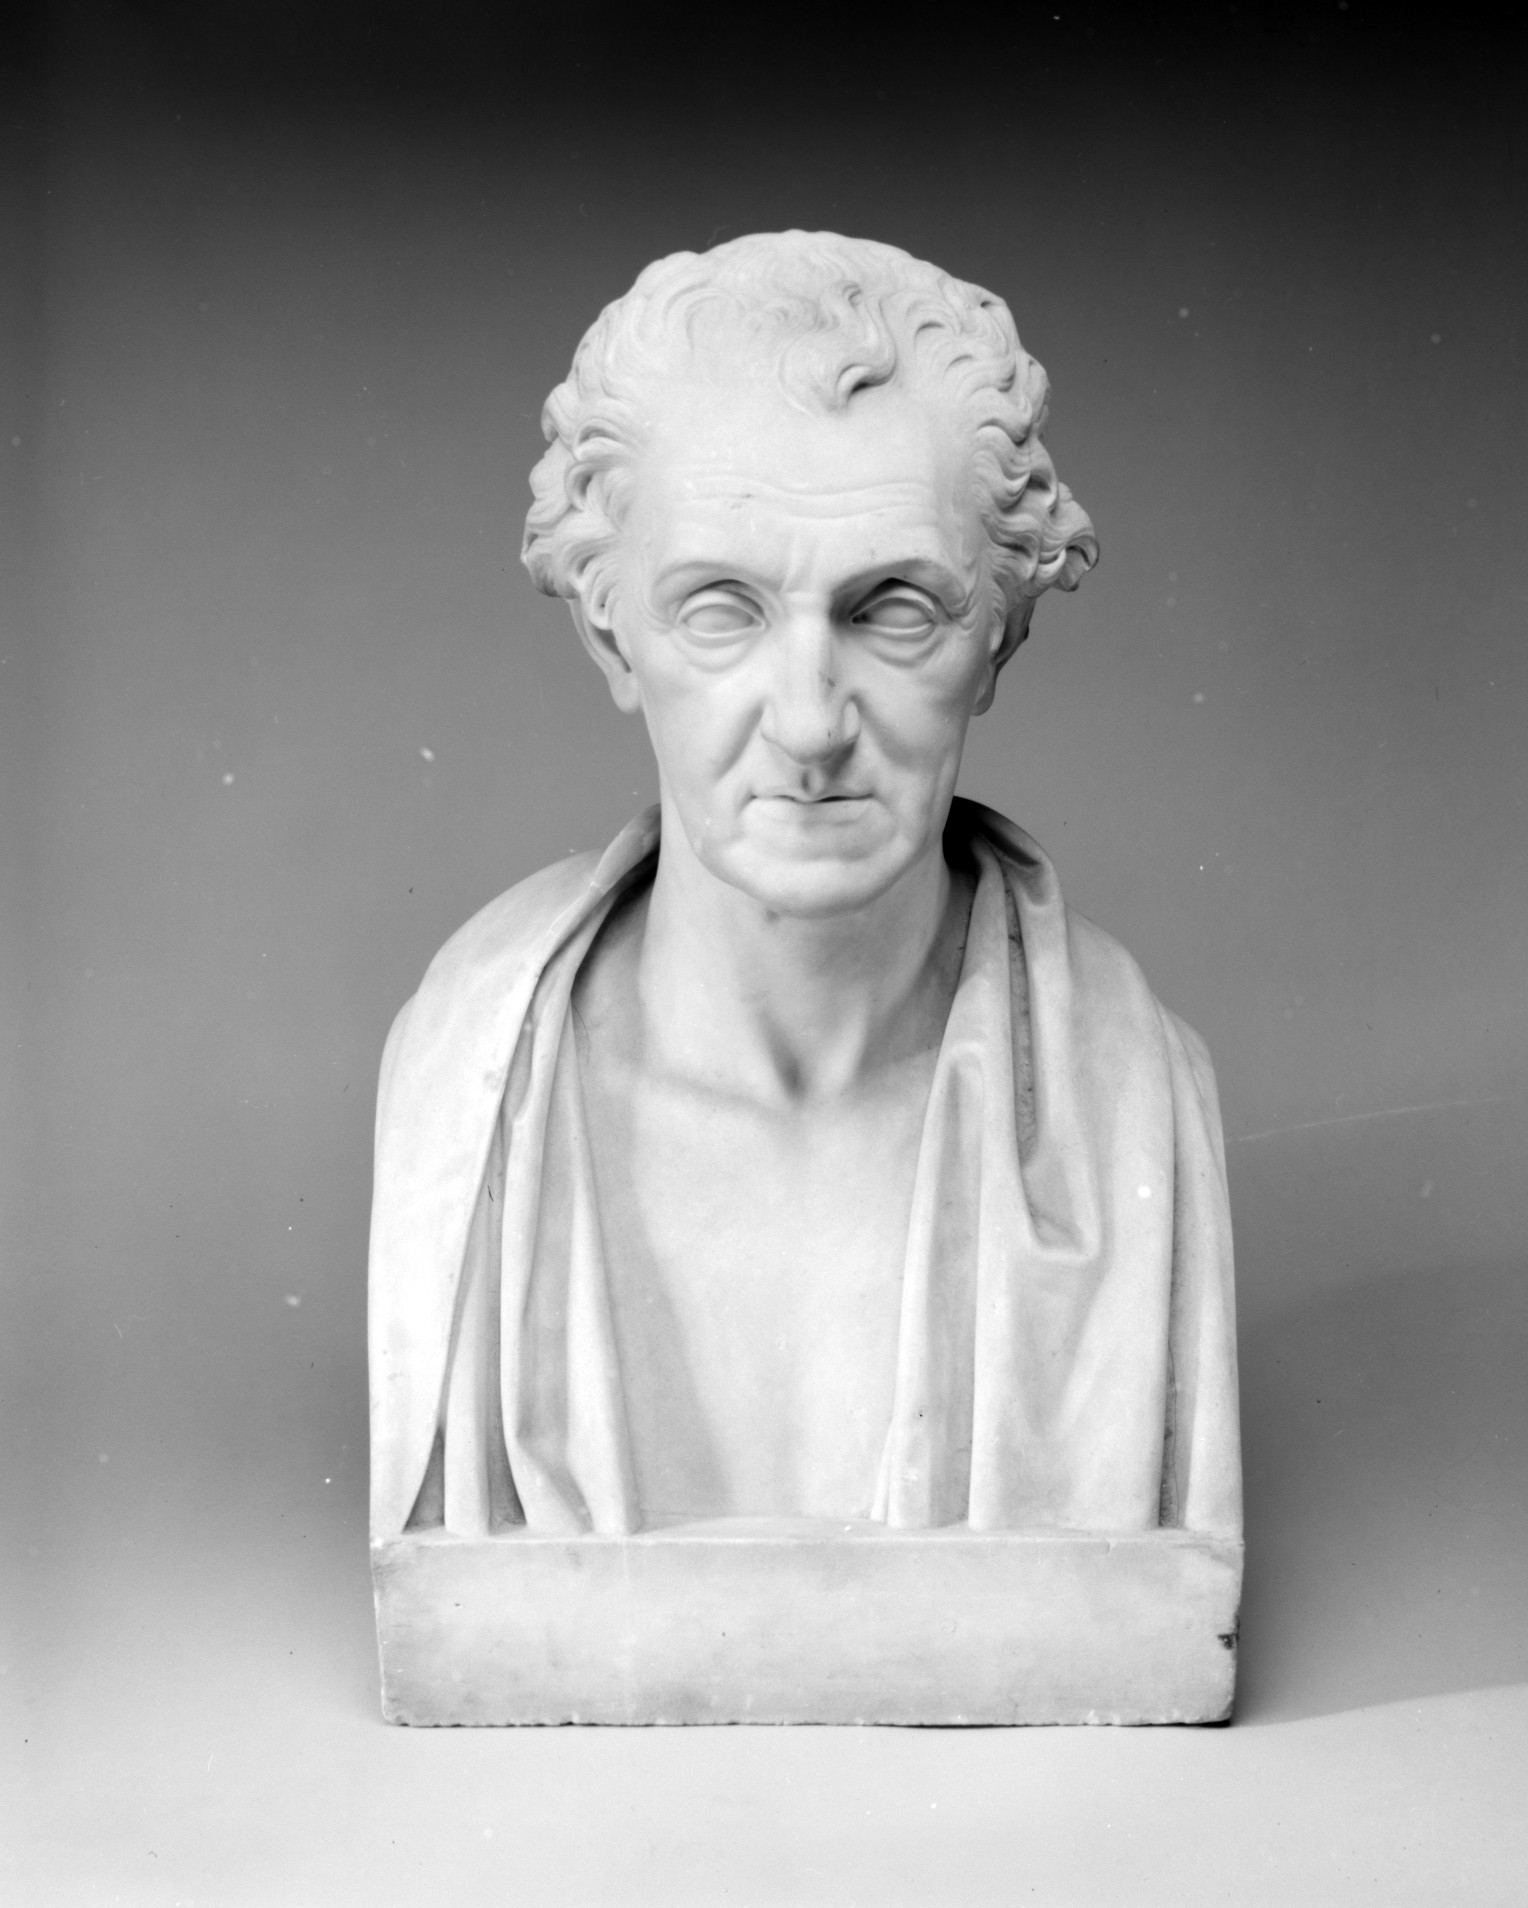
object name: bust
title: Bust of a gentleman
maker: john gibson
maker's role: artist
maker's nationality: british, born wales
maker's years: 1790-1866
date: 1830-1840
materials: marble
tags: men,portraits